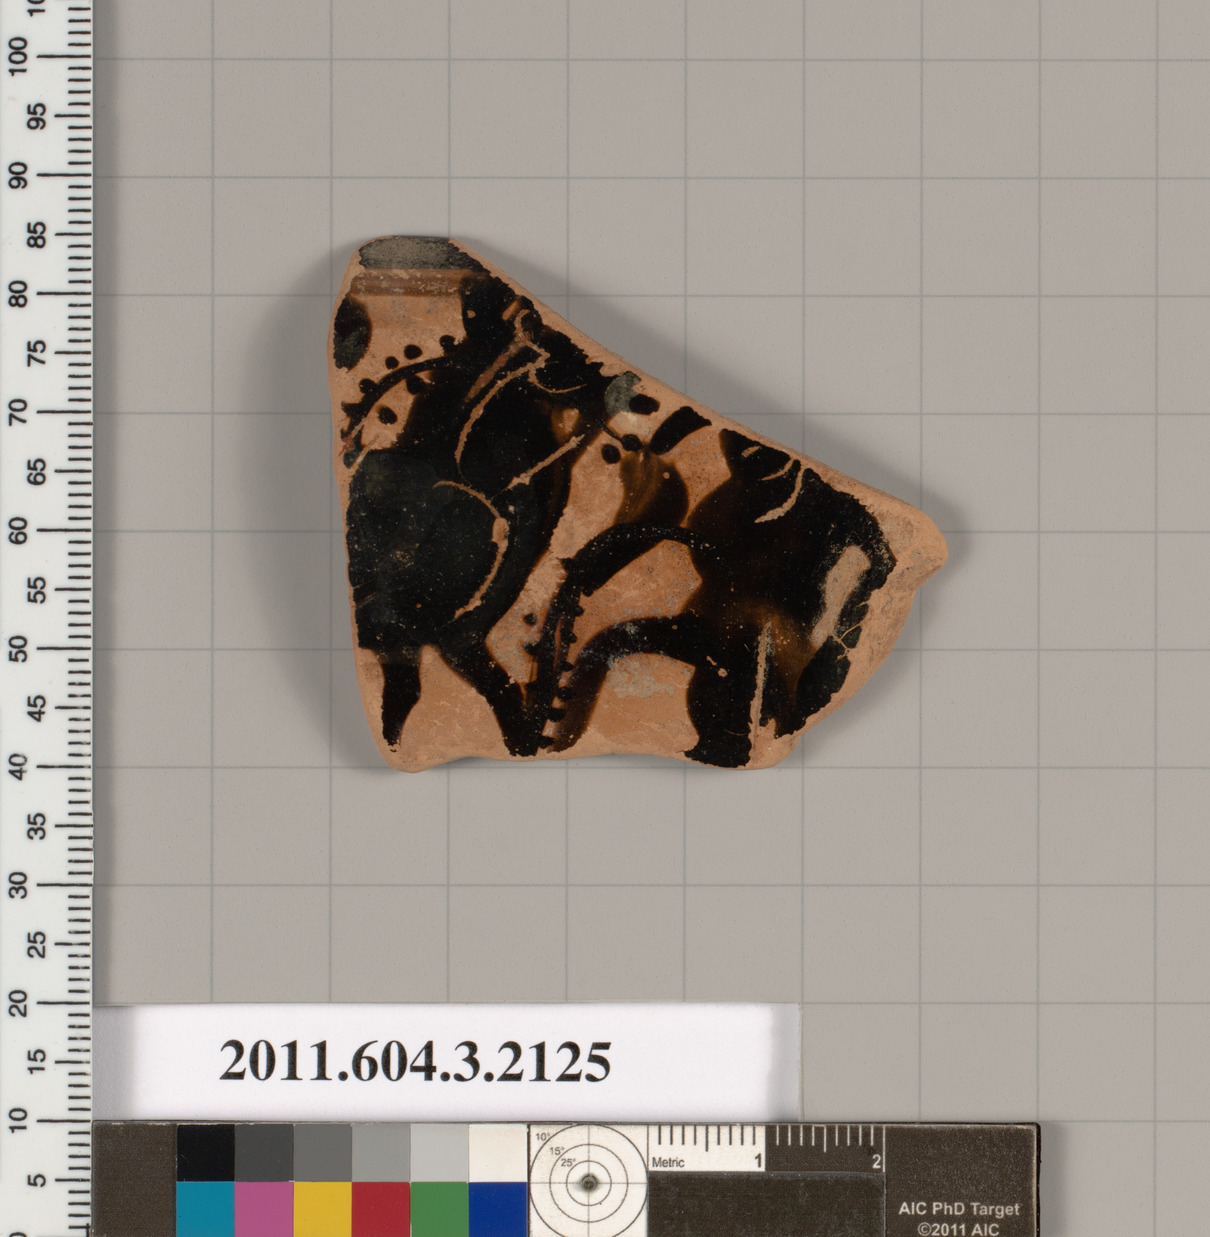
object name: kylix fragment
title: Terracotta rim fragment of a kylix (drinking cup)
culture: greek, attic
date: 500-468 BCE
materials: terracotta